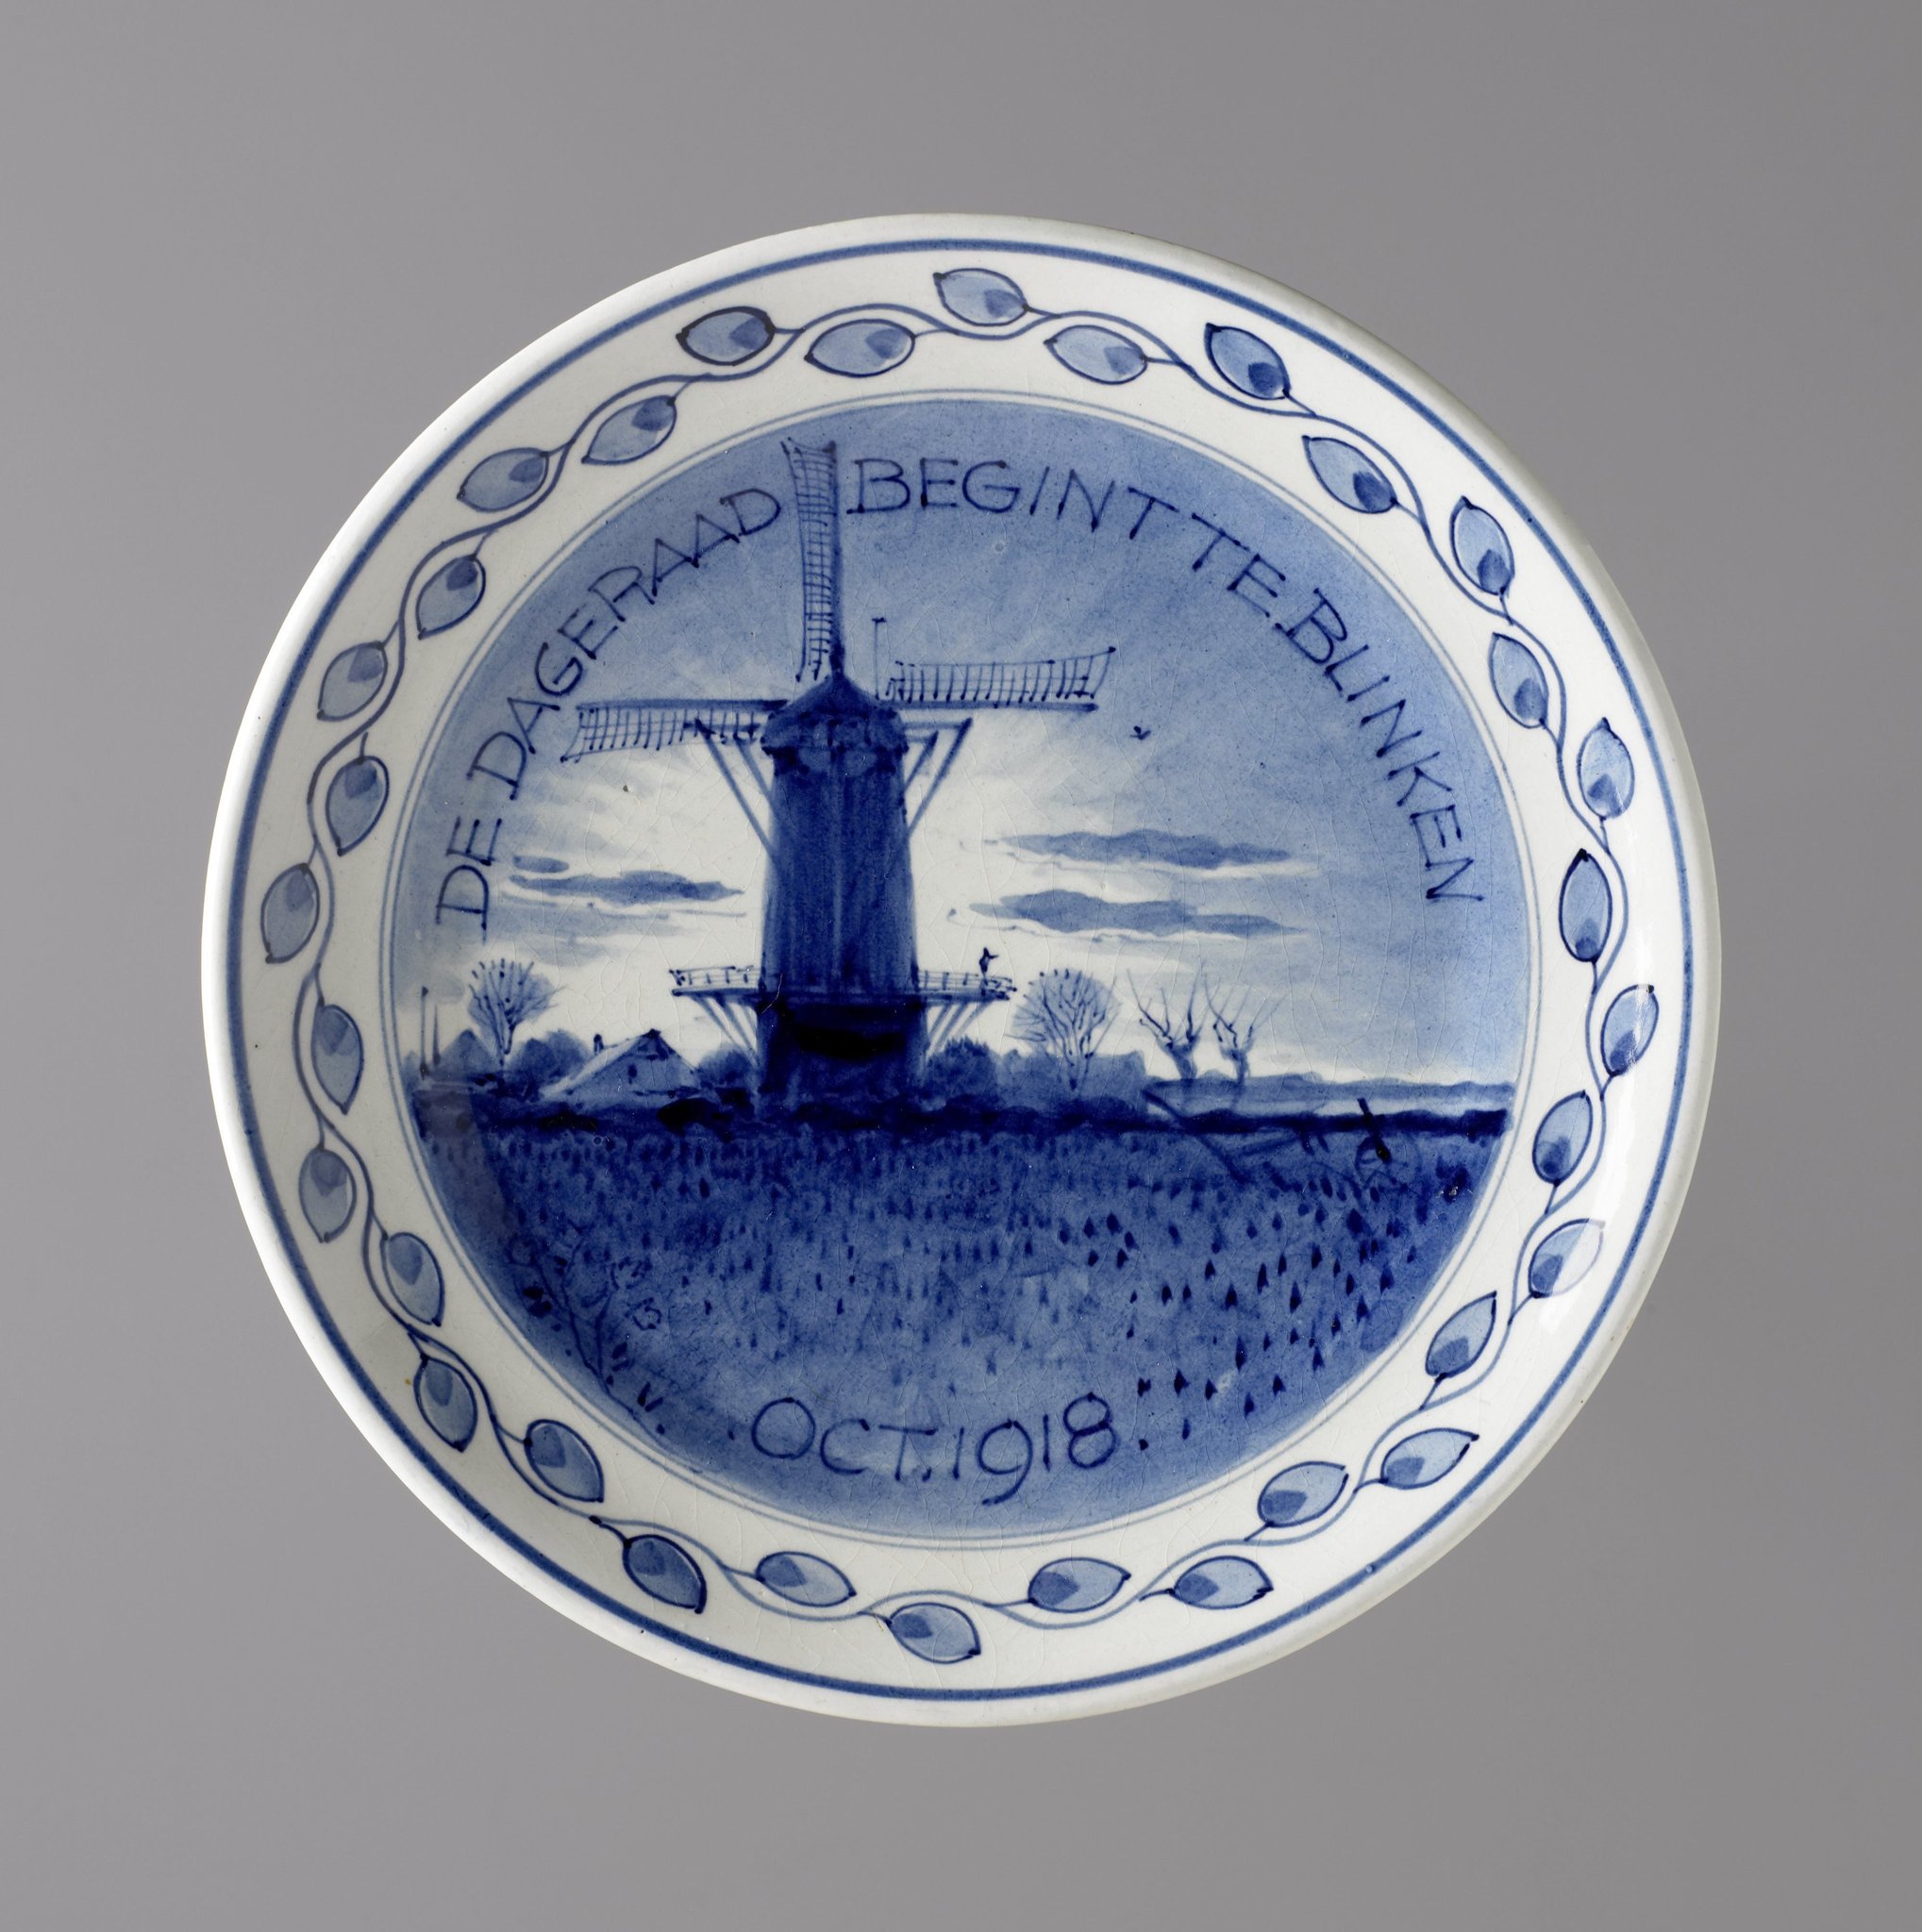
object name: herinneringsbord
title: Den dageraad begint te blinken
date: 1910-1918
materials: earthenware, glaze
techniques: painted, vitrification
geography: delft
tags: netherlands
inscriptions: date: ‘OCT 1918’, factory mark: ‘JT Delft’, title: ‘DEN DAGERAAD BEGINT TE BLINKEN’, mark: ‘VP. 914’, check stamp: ‘8’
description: Bord, blauw geschilderd met afbeelding van een molen op het land, links een huis met hooiberg. Op de molengang een persoon. Met opschrift. Achterzijde v.z.v. twee gaatjes en ijzerdraad om bord op te hangen. Gemerkt.